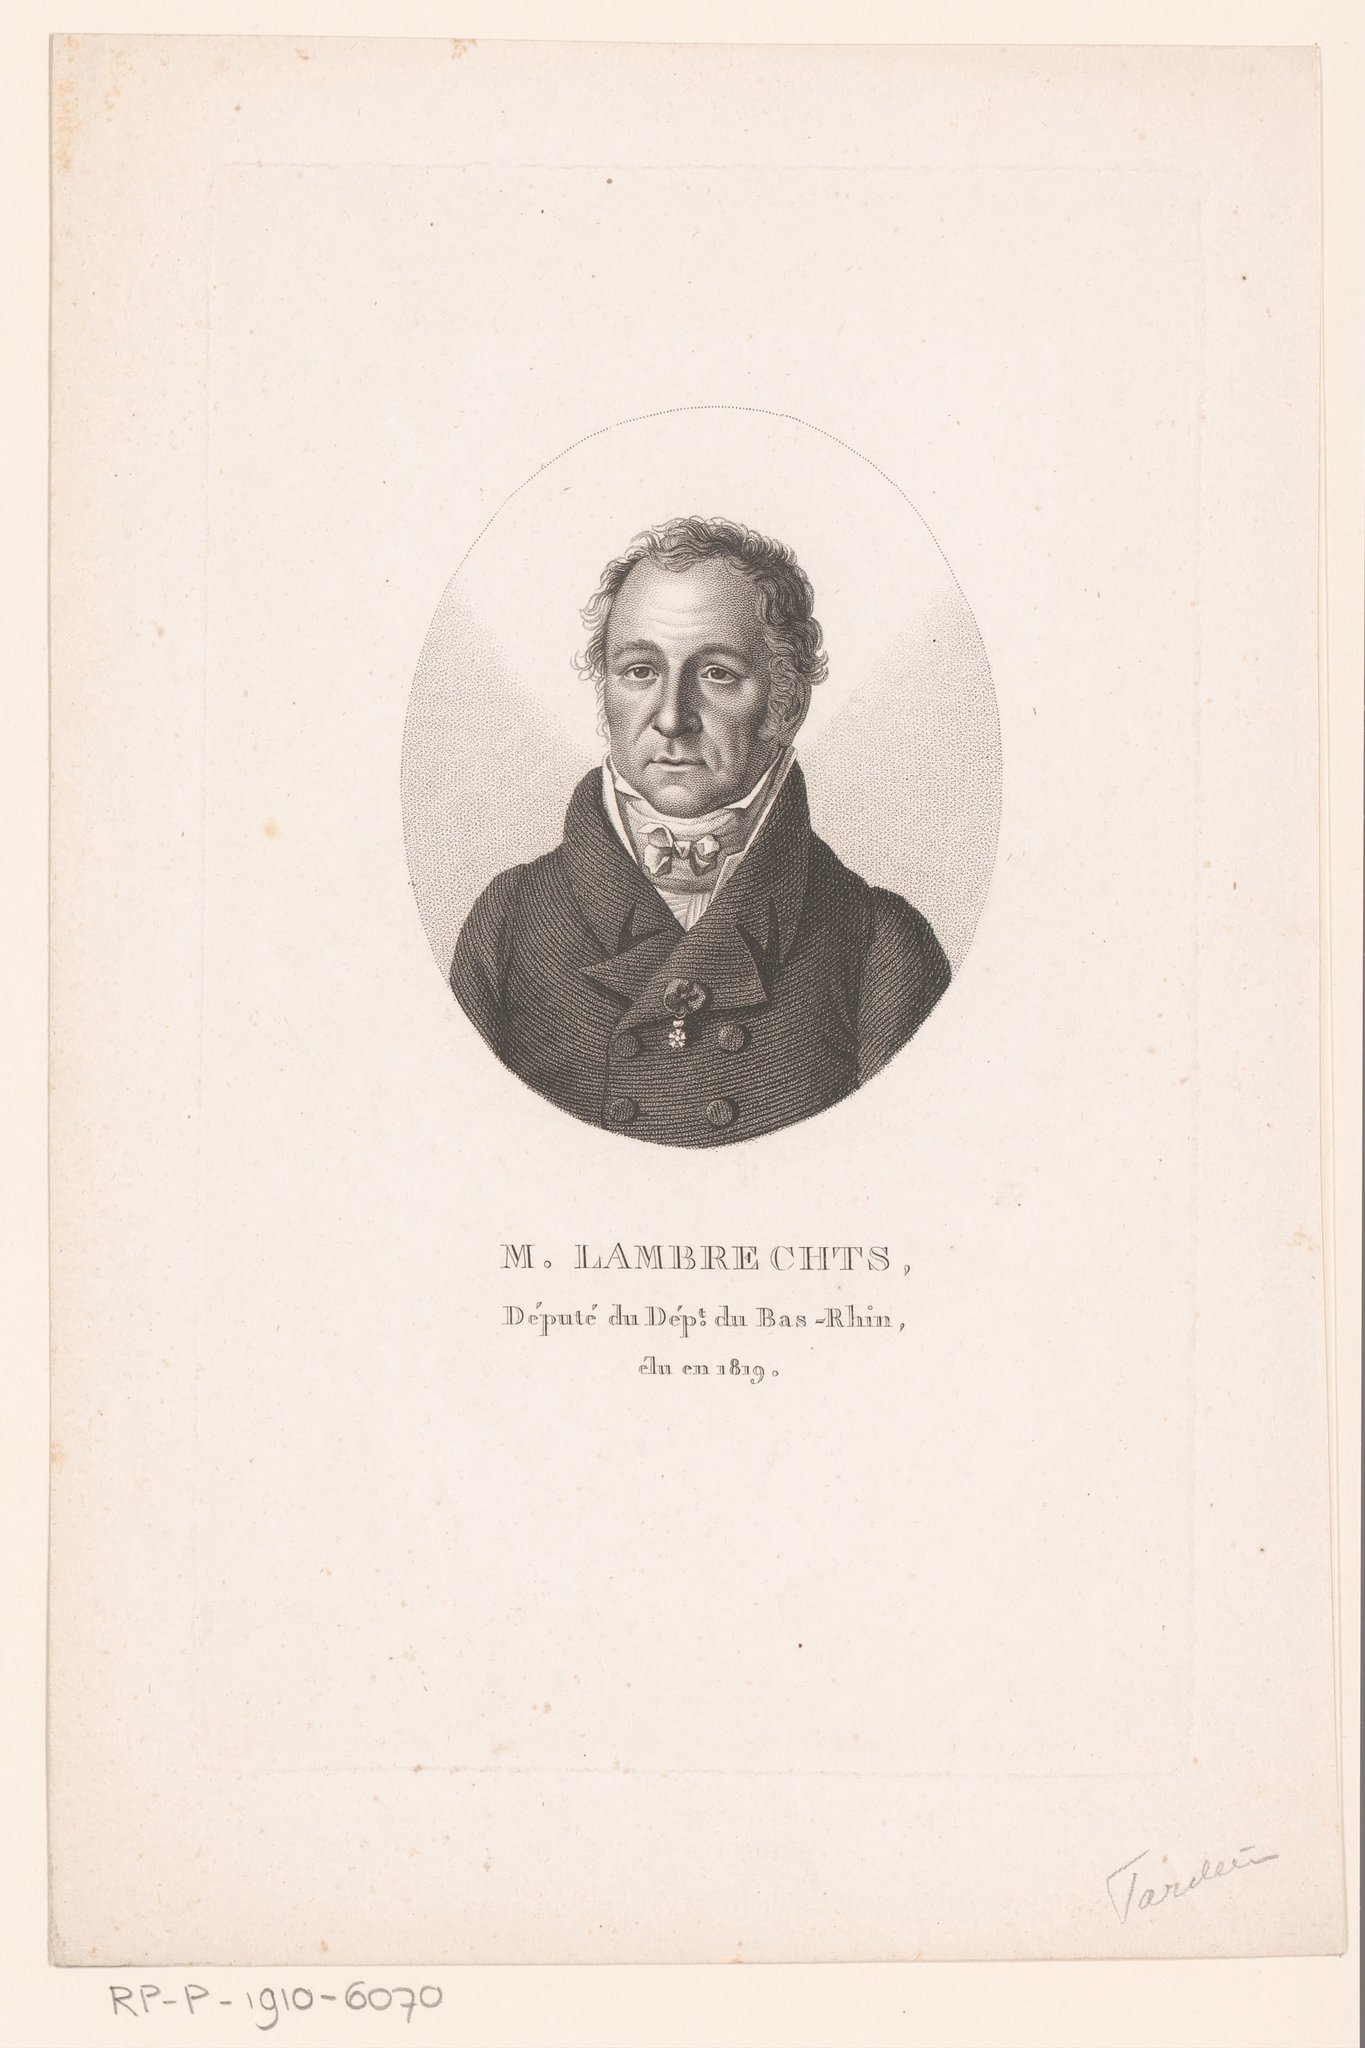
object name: book illustration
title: Portret van Charles Joseph Mathieu Lambrechts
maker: ambroise tardieu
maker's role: print maker, printer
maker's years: 1788-1841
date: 1820-1821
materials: paper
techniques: engraving, roulette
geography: paris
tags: sint-truiden, politician, historical persons, politician, e.g. party leader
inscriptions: collector's mark: Lugt 2228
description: Prent uit: Tardieu, Ambroise. Portraits des députés, écrivains et pairs constitutionnels, défenseurs invariables de la charte et de la loi des élections du 5 février 1817. Parijs: Tardieu, Ambroise, 1820-1821.